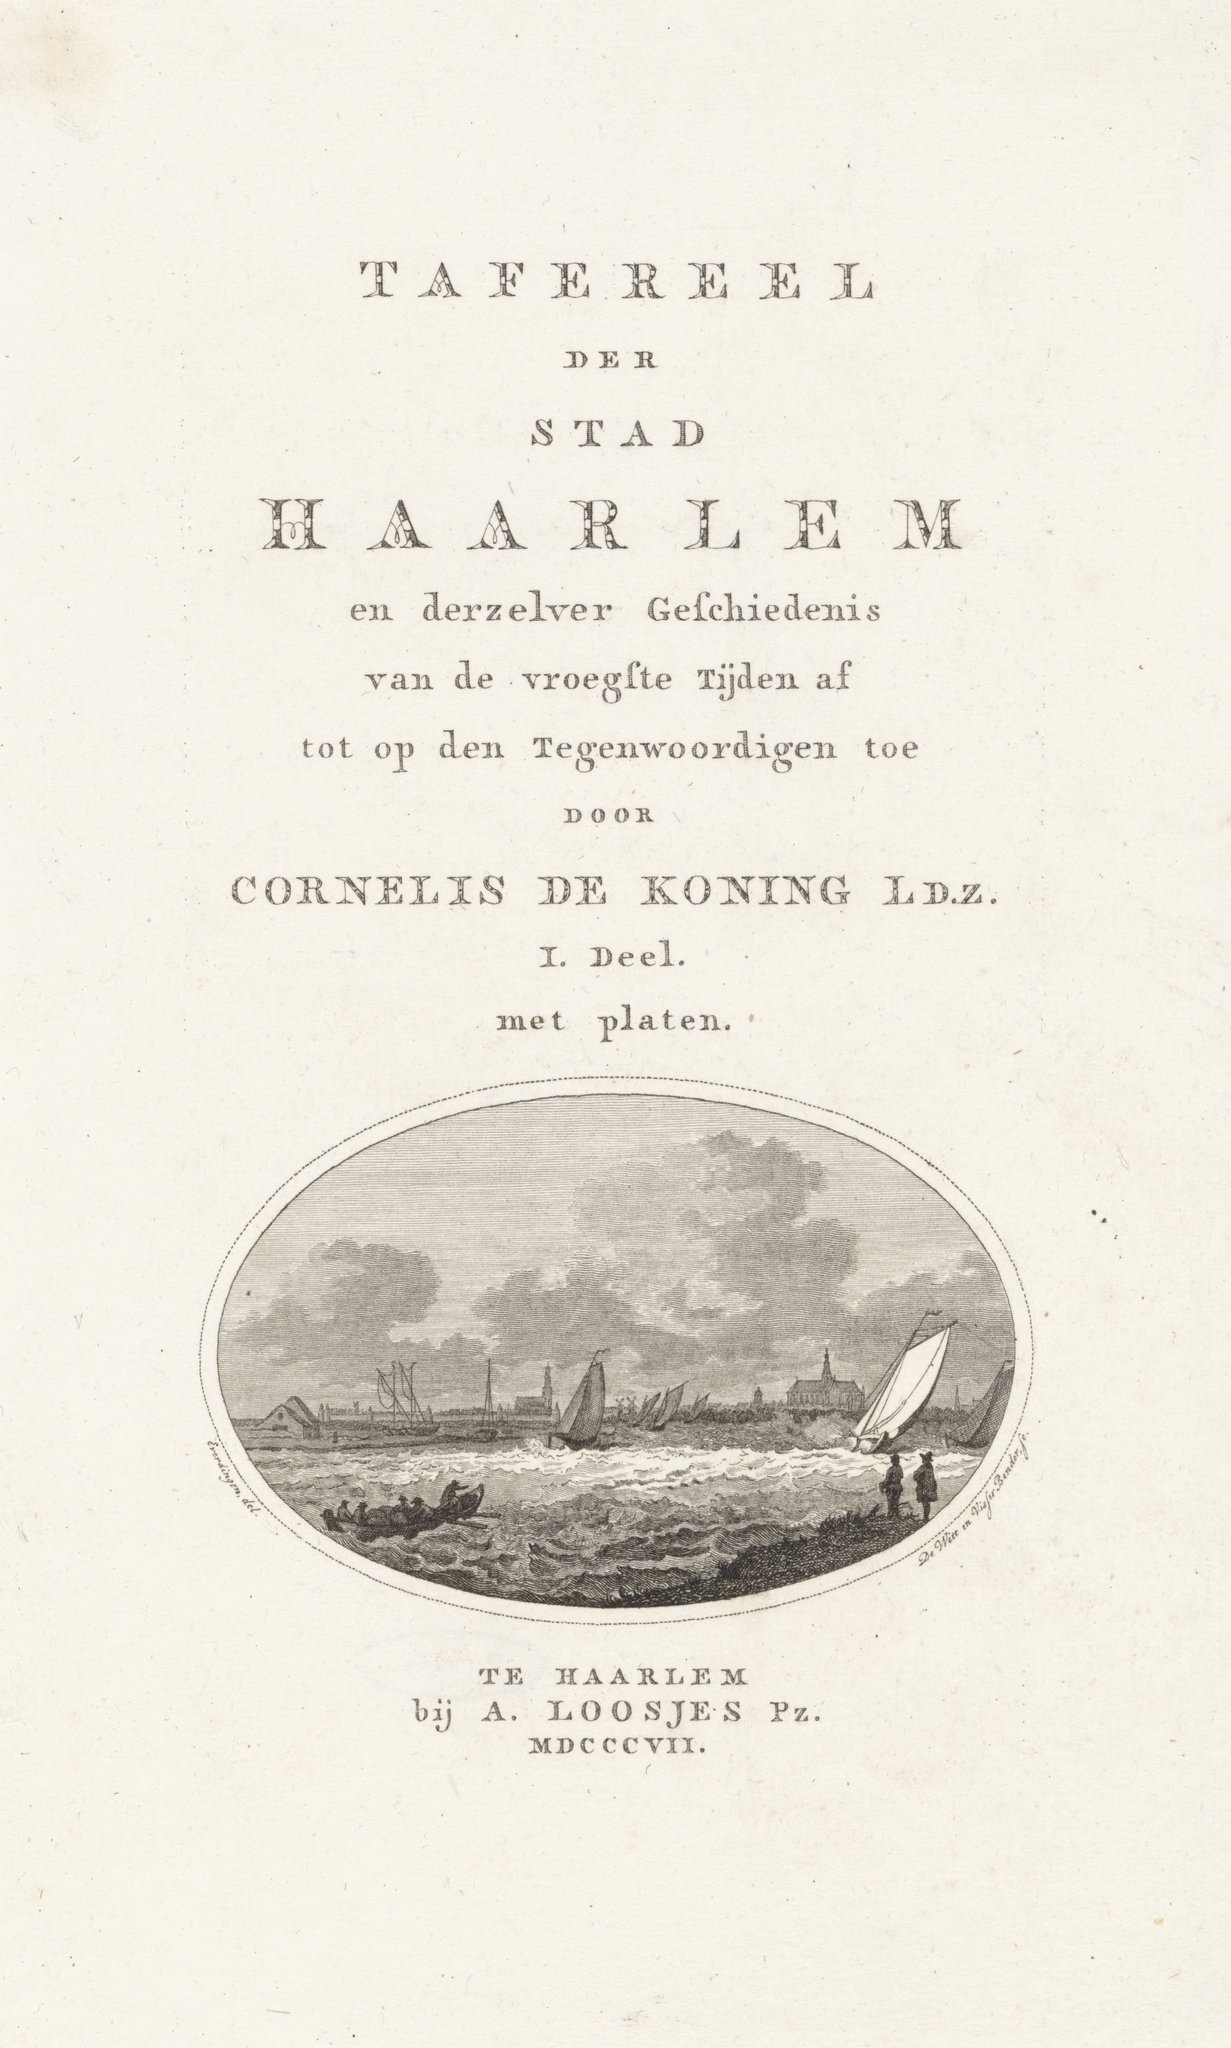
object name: titelblad, titelpagina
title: Gezicht op de Haarlemmermeer, met Haarlem op de achtergrond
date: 1807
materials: paper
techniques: etching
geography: haarlem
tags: sailing-ship, sailing-boat, prospect of city, town panorama, silhouette of city, haarlem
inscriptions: collector's mark: Lugt 2228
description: Titelpagina voor: Koning, Cornelis de. Tafereel der stad Haarlem : en derzelver geschiedenis van de vroegste tijden af tot op den tegenwoordigen toe. 4 dln. Haarlem: Adriaan Pietersz. Loosjes, 1807-1808.